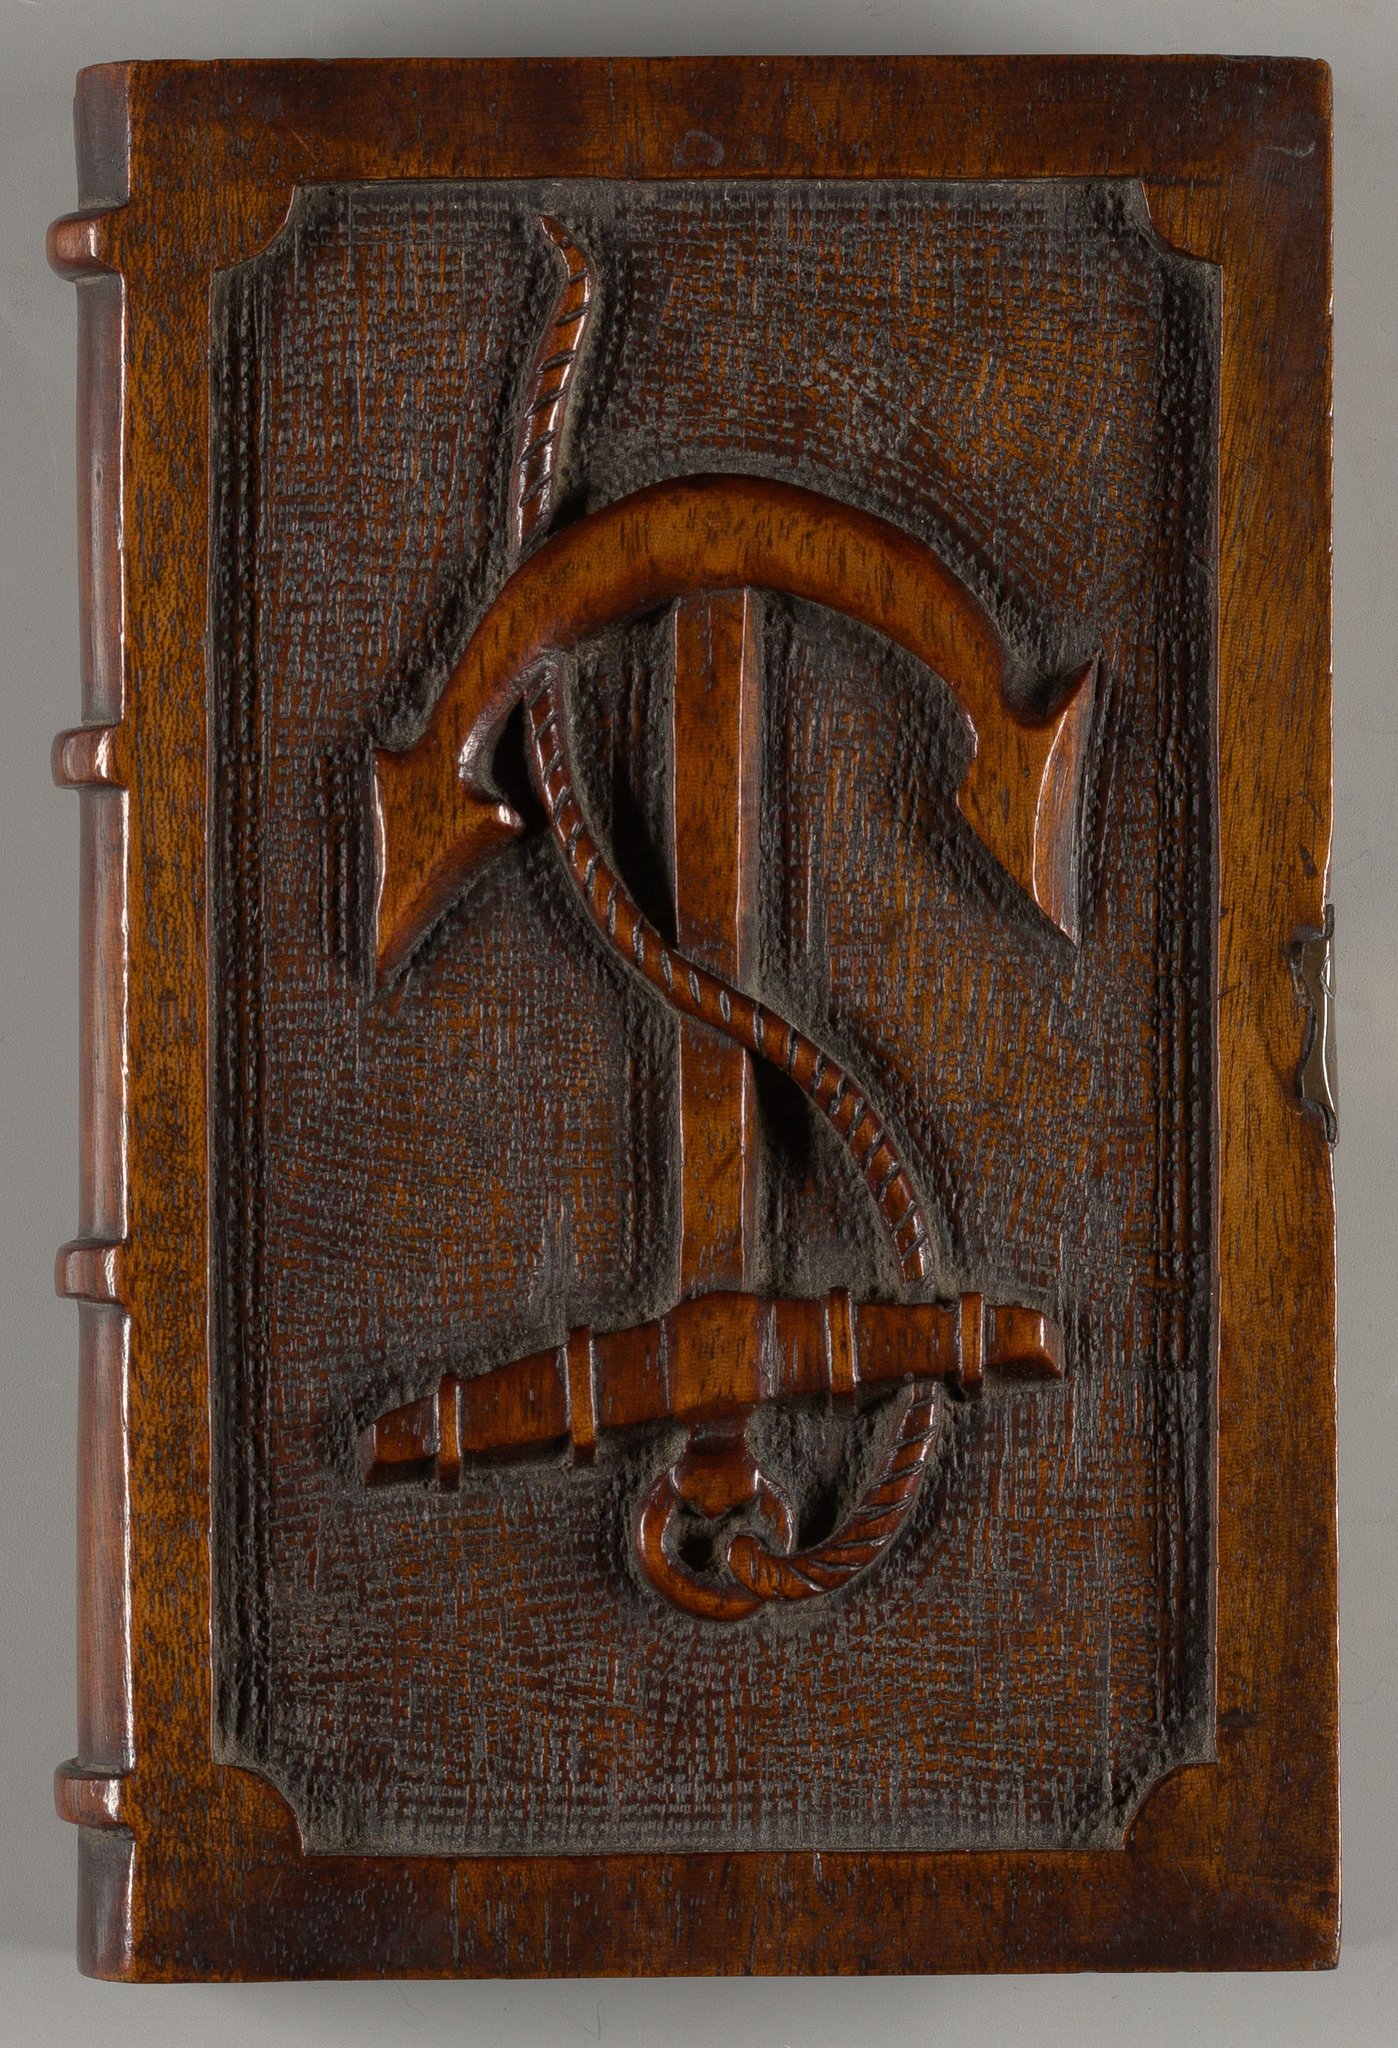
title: Relic of the Eurydice. Lost March 24, 1878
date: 1878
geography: united kingdom